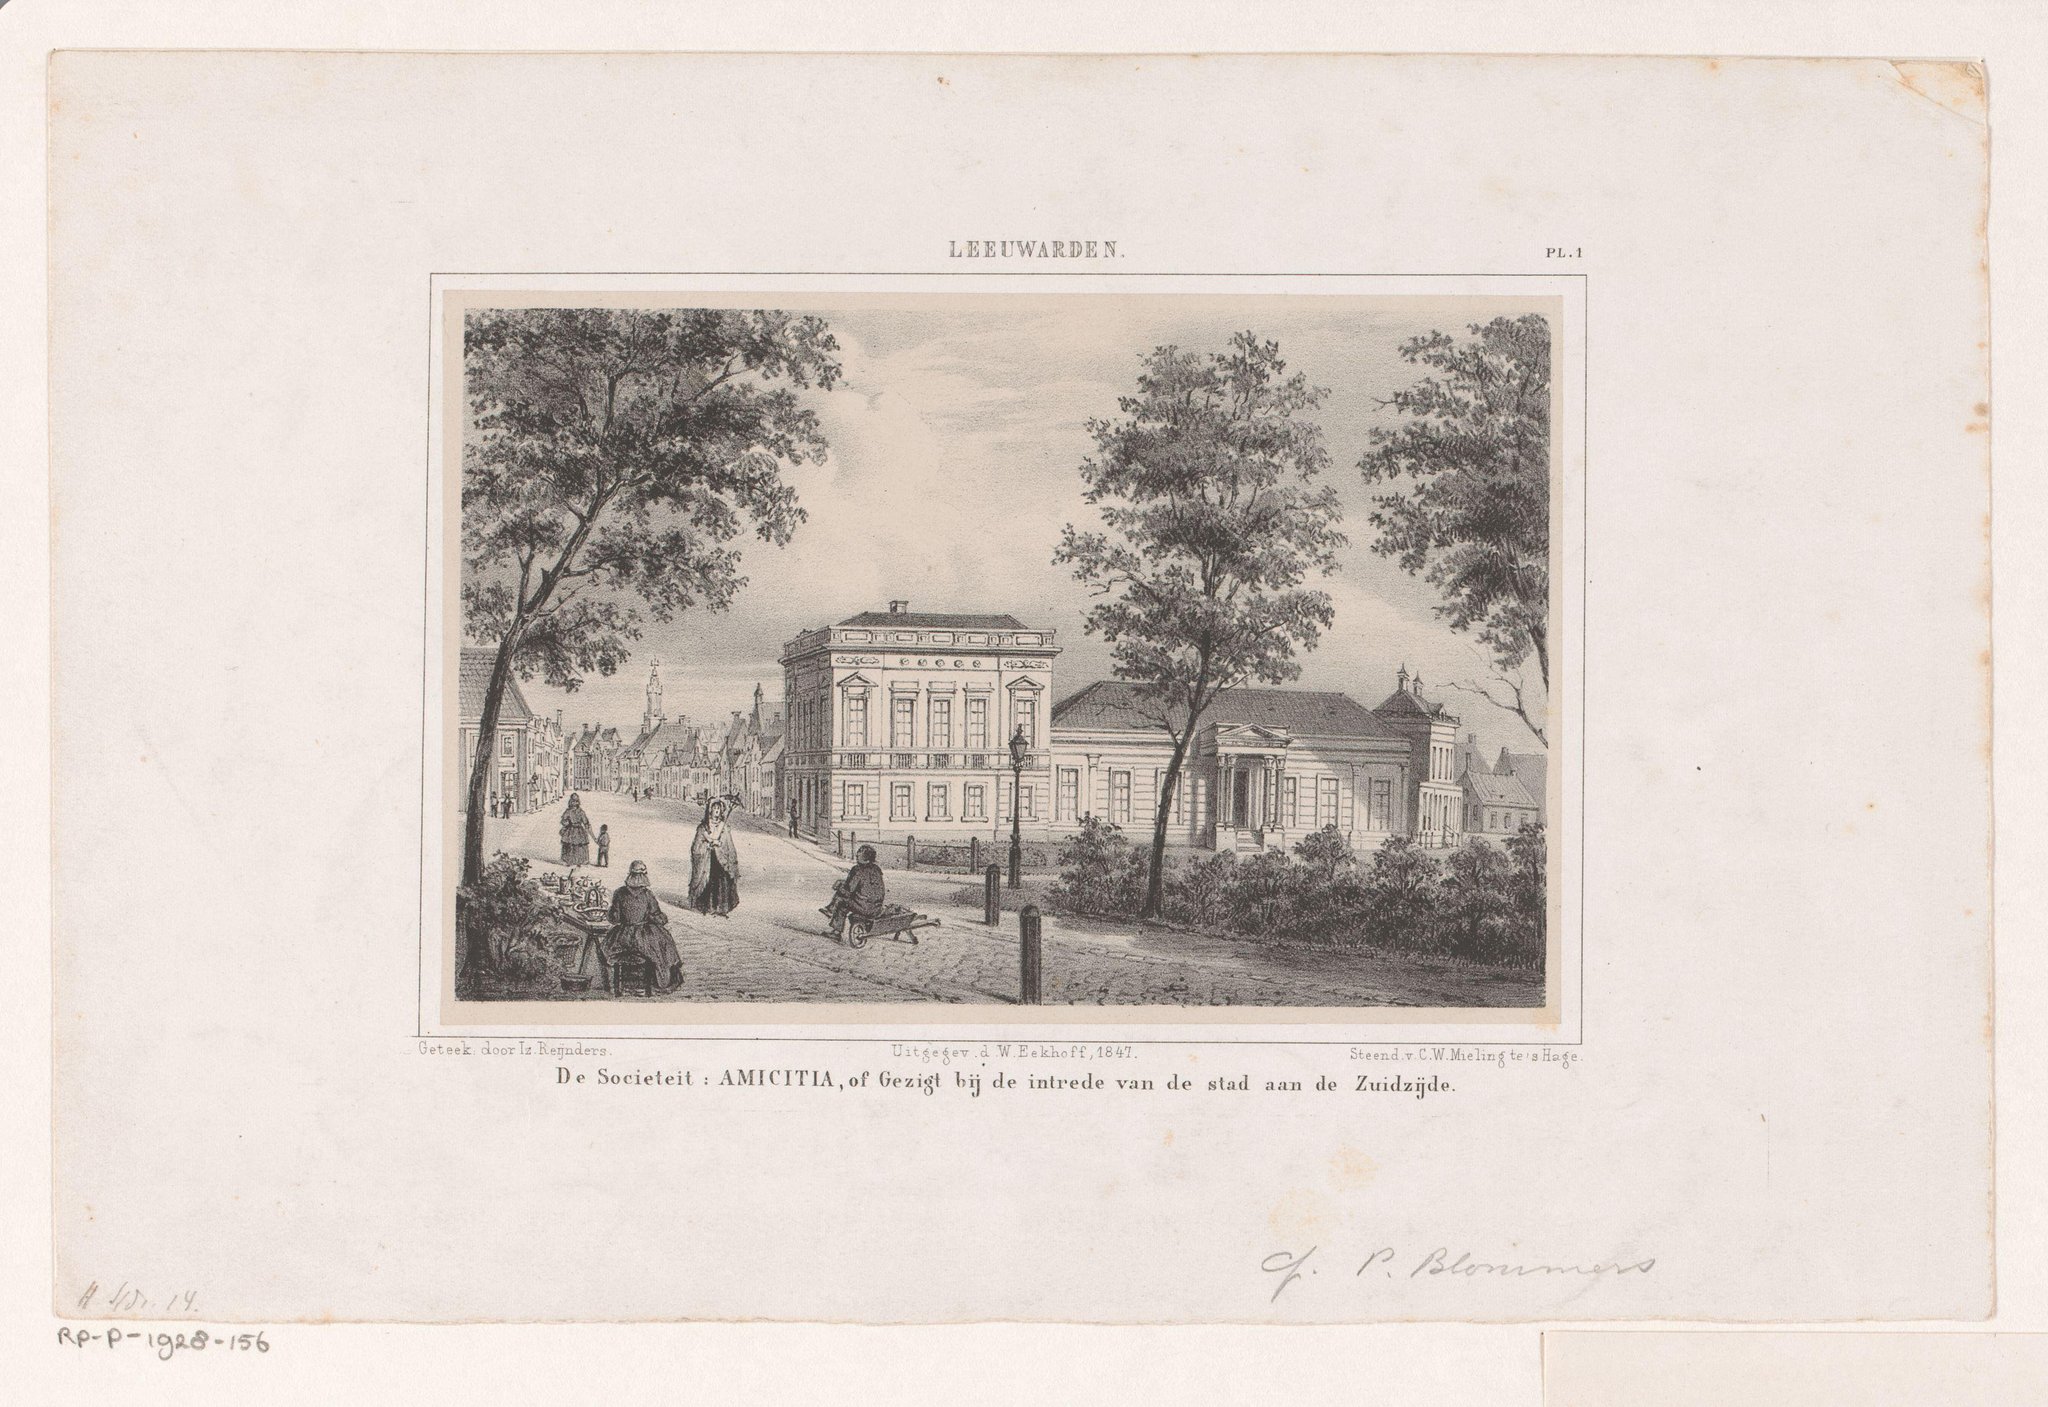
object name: print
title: Gezicht op sociëteit Amicitia in Leeuwarden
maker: w. eekhoff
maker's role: publisher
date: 1847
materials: paper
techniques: lithograph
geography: leeuwarden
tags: club, meeting place, city-view in general; 'veduta' (+ city(-scape) with figures, staffage)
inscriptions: collector's mark: Lugt 2228